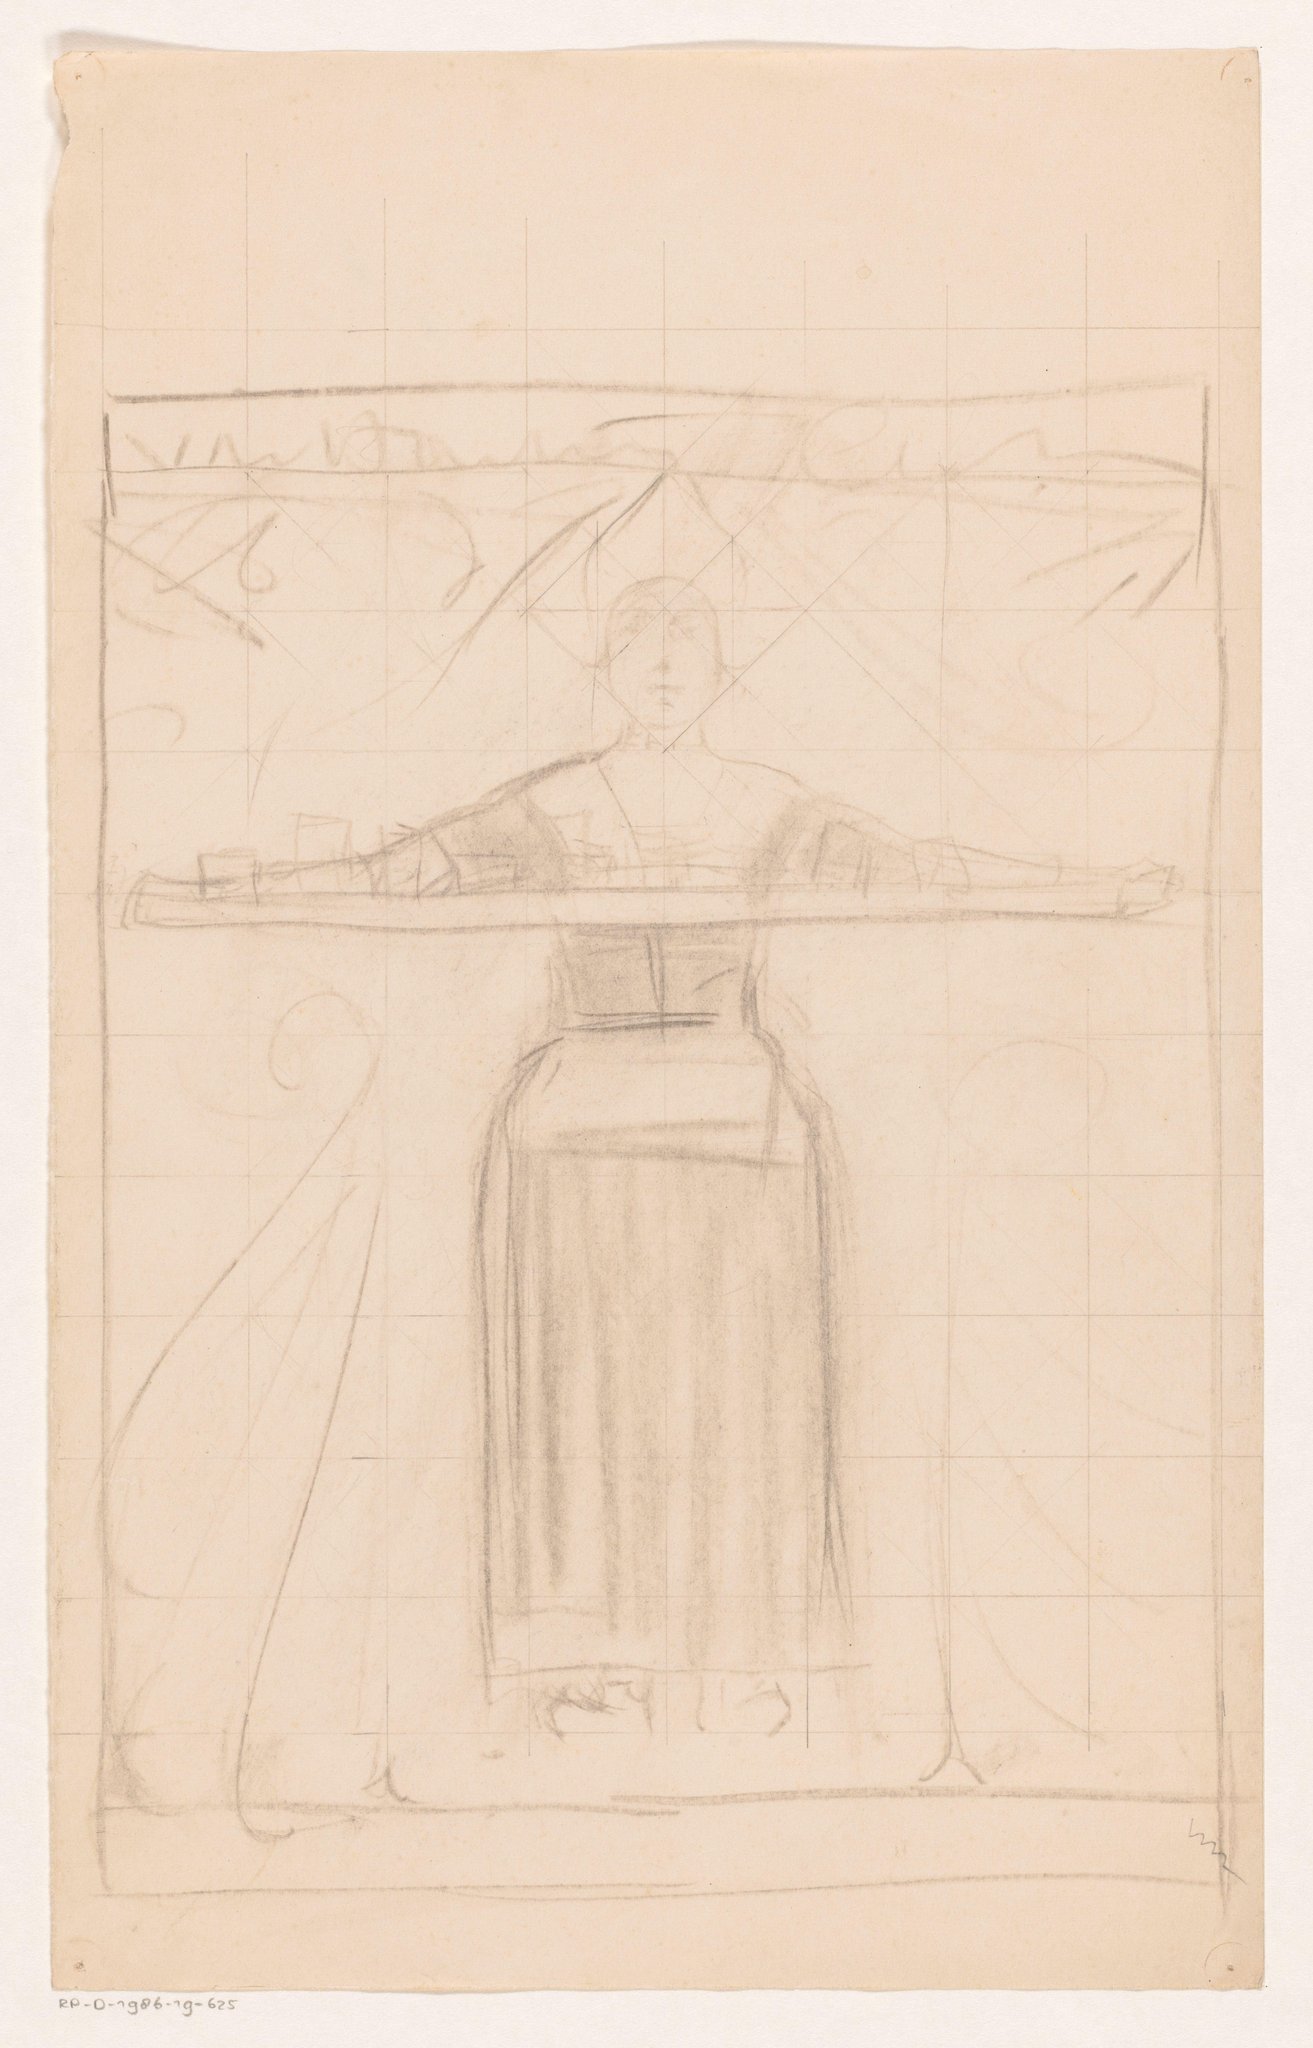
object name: design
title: Ontwerp voor een advertentie voor Van Houten's Chocolade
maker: reinier willem petrus de vries (1874-1953)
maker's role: draughtsman, print maker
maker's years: 1874-1953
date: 1884-1952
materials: chalk, paper, pencil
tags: chocolate (solid), folk costume, regional costume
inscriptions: collector's mark: ‘R:MVS.’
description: Een meisje in klederdracht draagt een dienblad met chocolade.